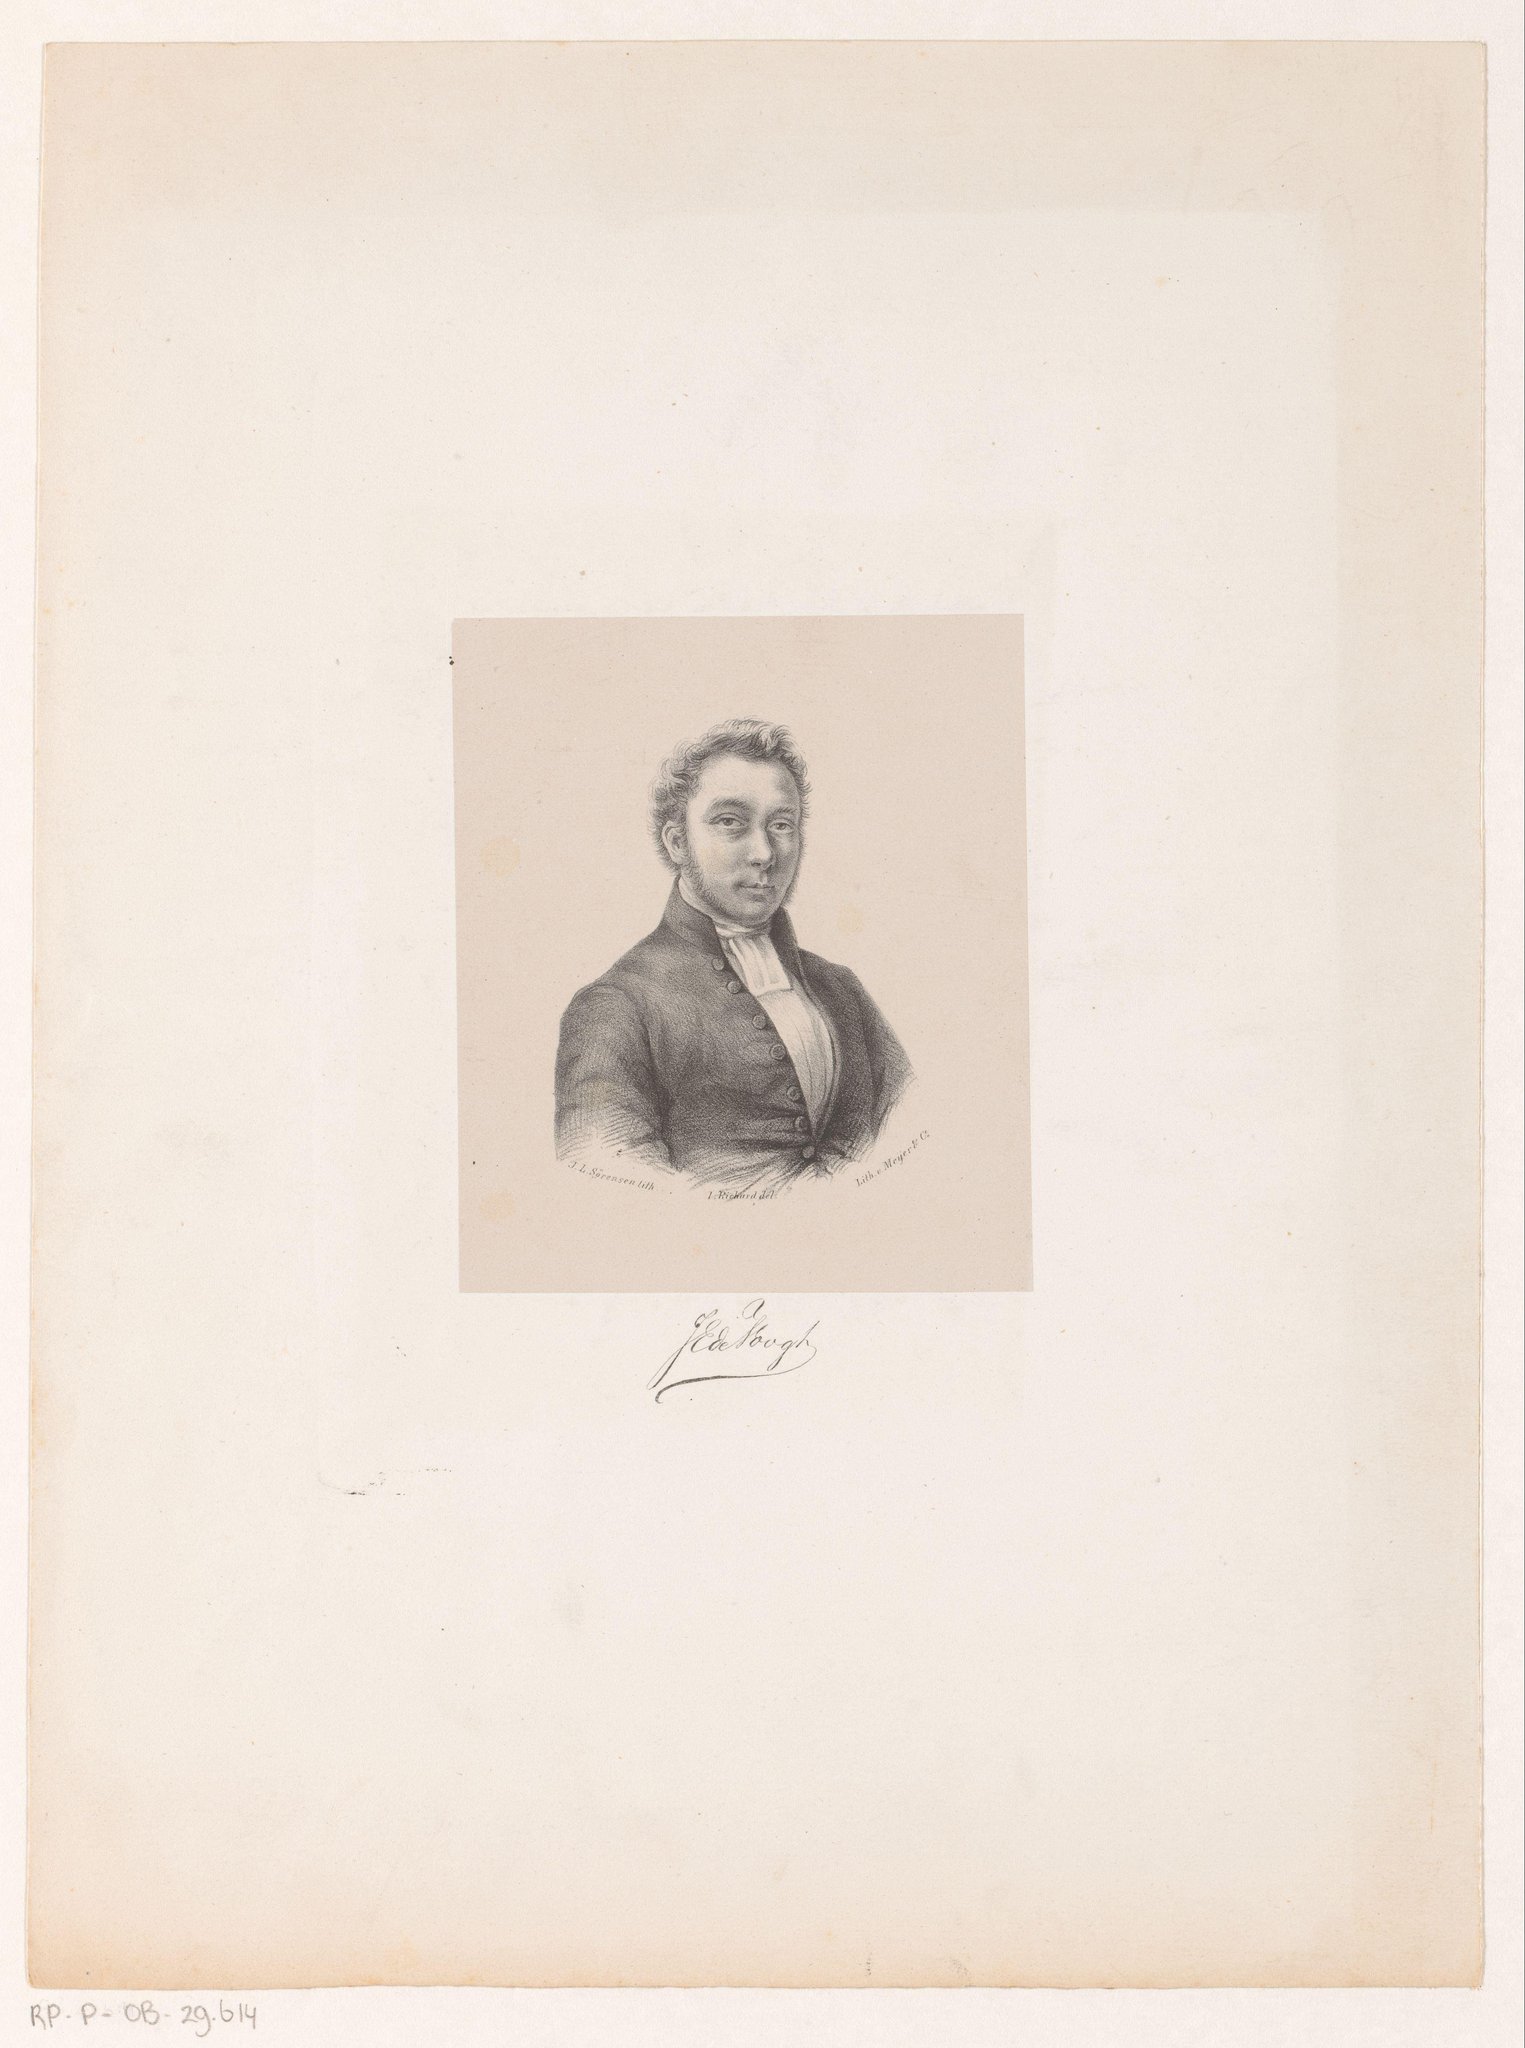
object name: print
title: Portret van Johannes Everhardus Voogt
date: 1843-1856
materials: paper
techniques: lithograph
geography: amsterdam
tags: historical persons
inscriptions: collector's mark: Lugt 2228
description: Onder het portret de signatuur van de geportretteerde.